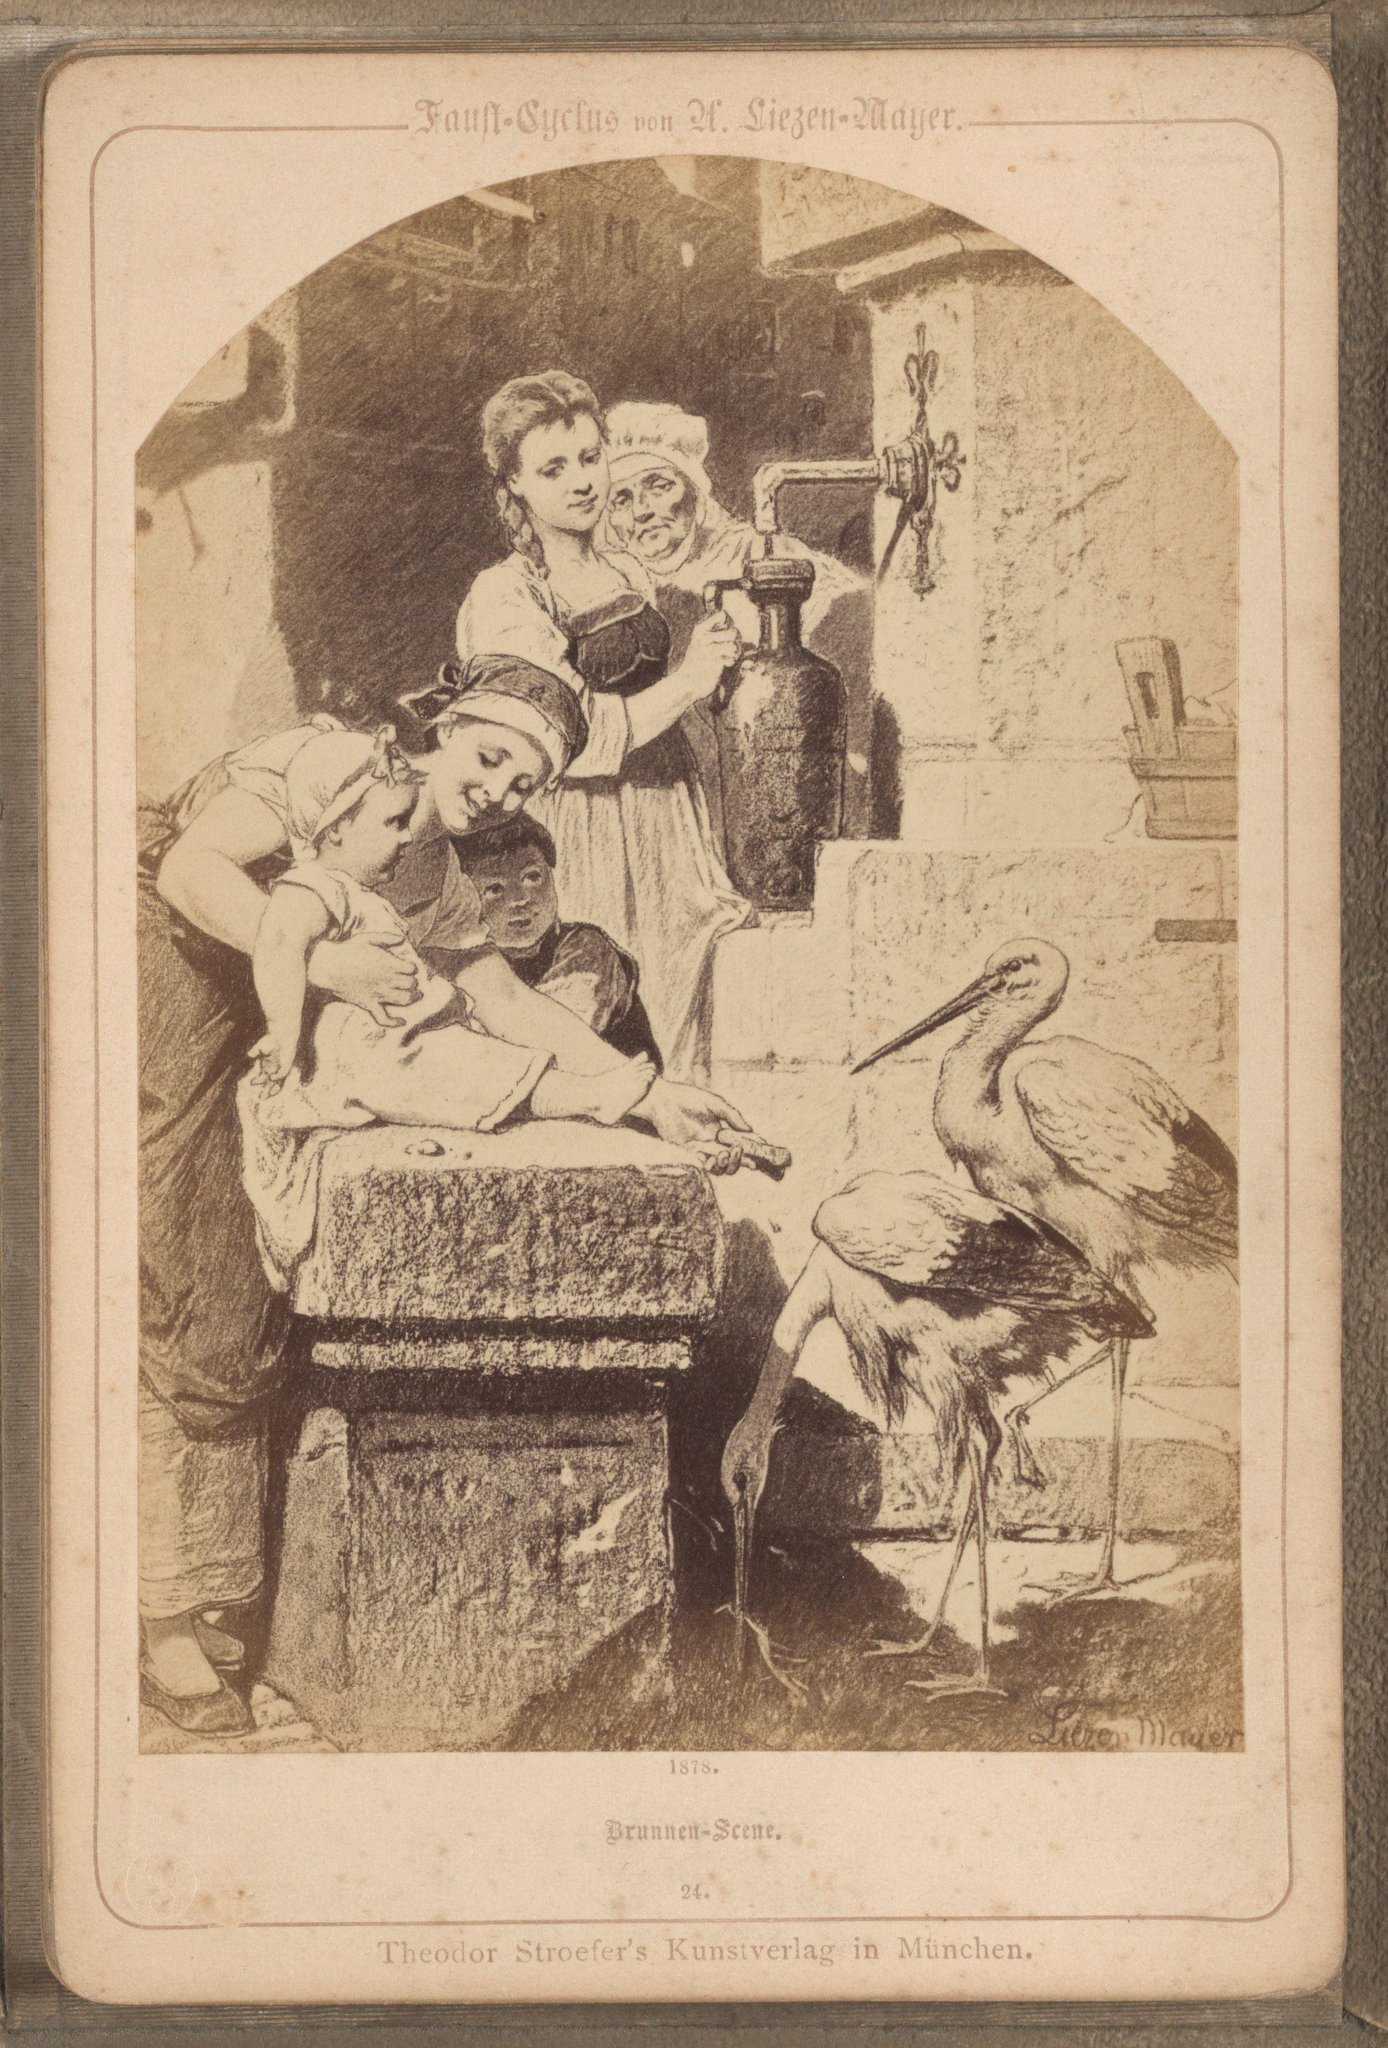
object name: photograph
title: Brunnen-Scene.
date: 1878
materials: cardboard, paper, photographic support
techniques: albumen print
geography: munich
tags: well, adolescent, young woman, maiden, adult woman, shore-birds and wading-birds: stork, child, faust, spring (fluids extracted from the earth)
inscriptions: number: ‘24’, check stamp: ‘TS’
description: Onderdeel van Album met 30 fotoreproducties van tekeningen van het Faust-verhaal van J.W. von Goethe.